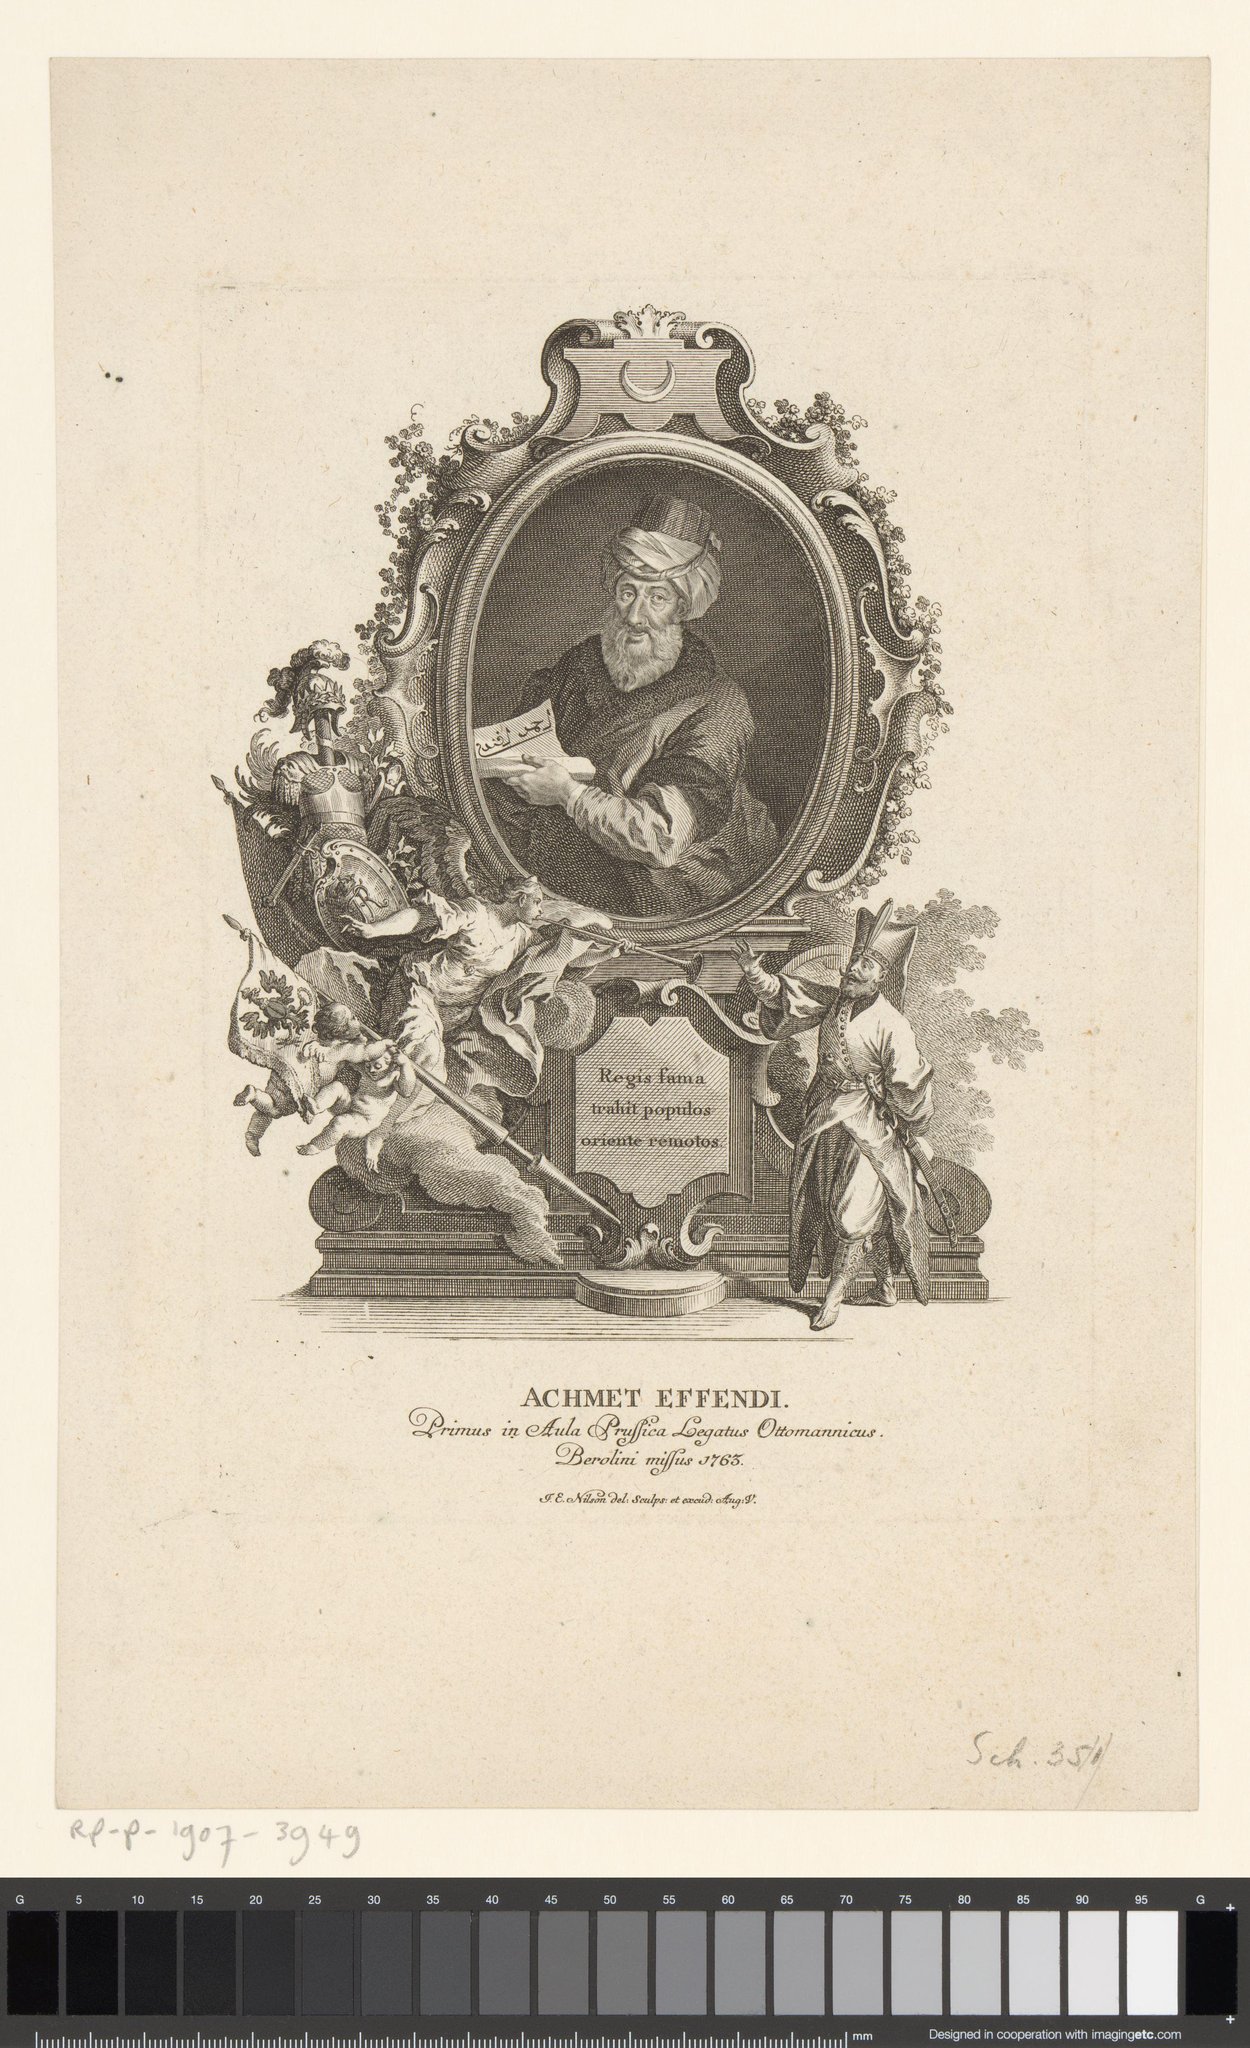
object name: print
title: Portret van Ahmed İbrahim Resmî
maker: johann esaias nilson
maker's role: draughtsman, print maker, publisher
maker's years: 1721-1788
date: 1765-1788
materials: paper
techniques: engraving, etching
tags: armour, historical persons, head-gear: turban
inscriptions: collector's mark: Lugt 2228